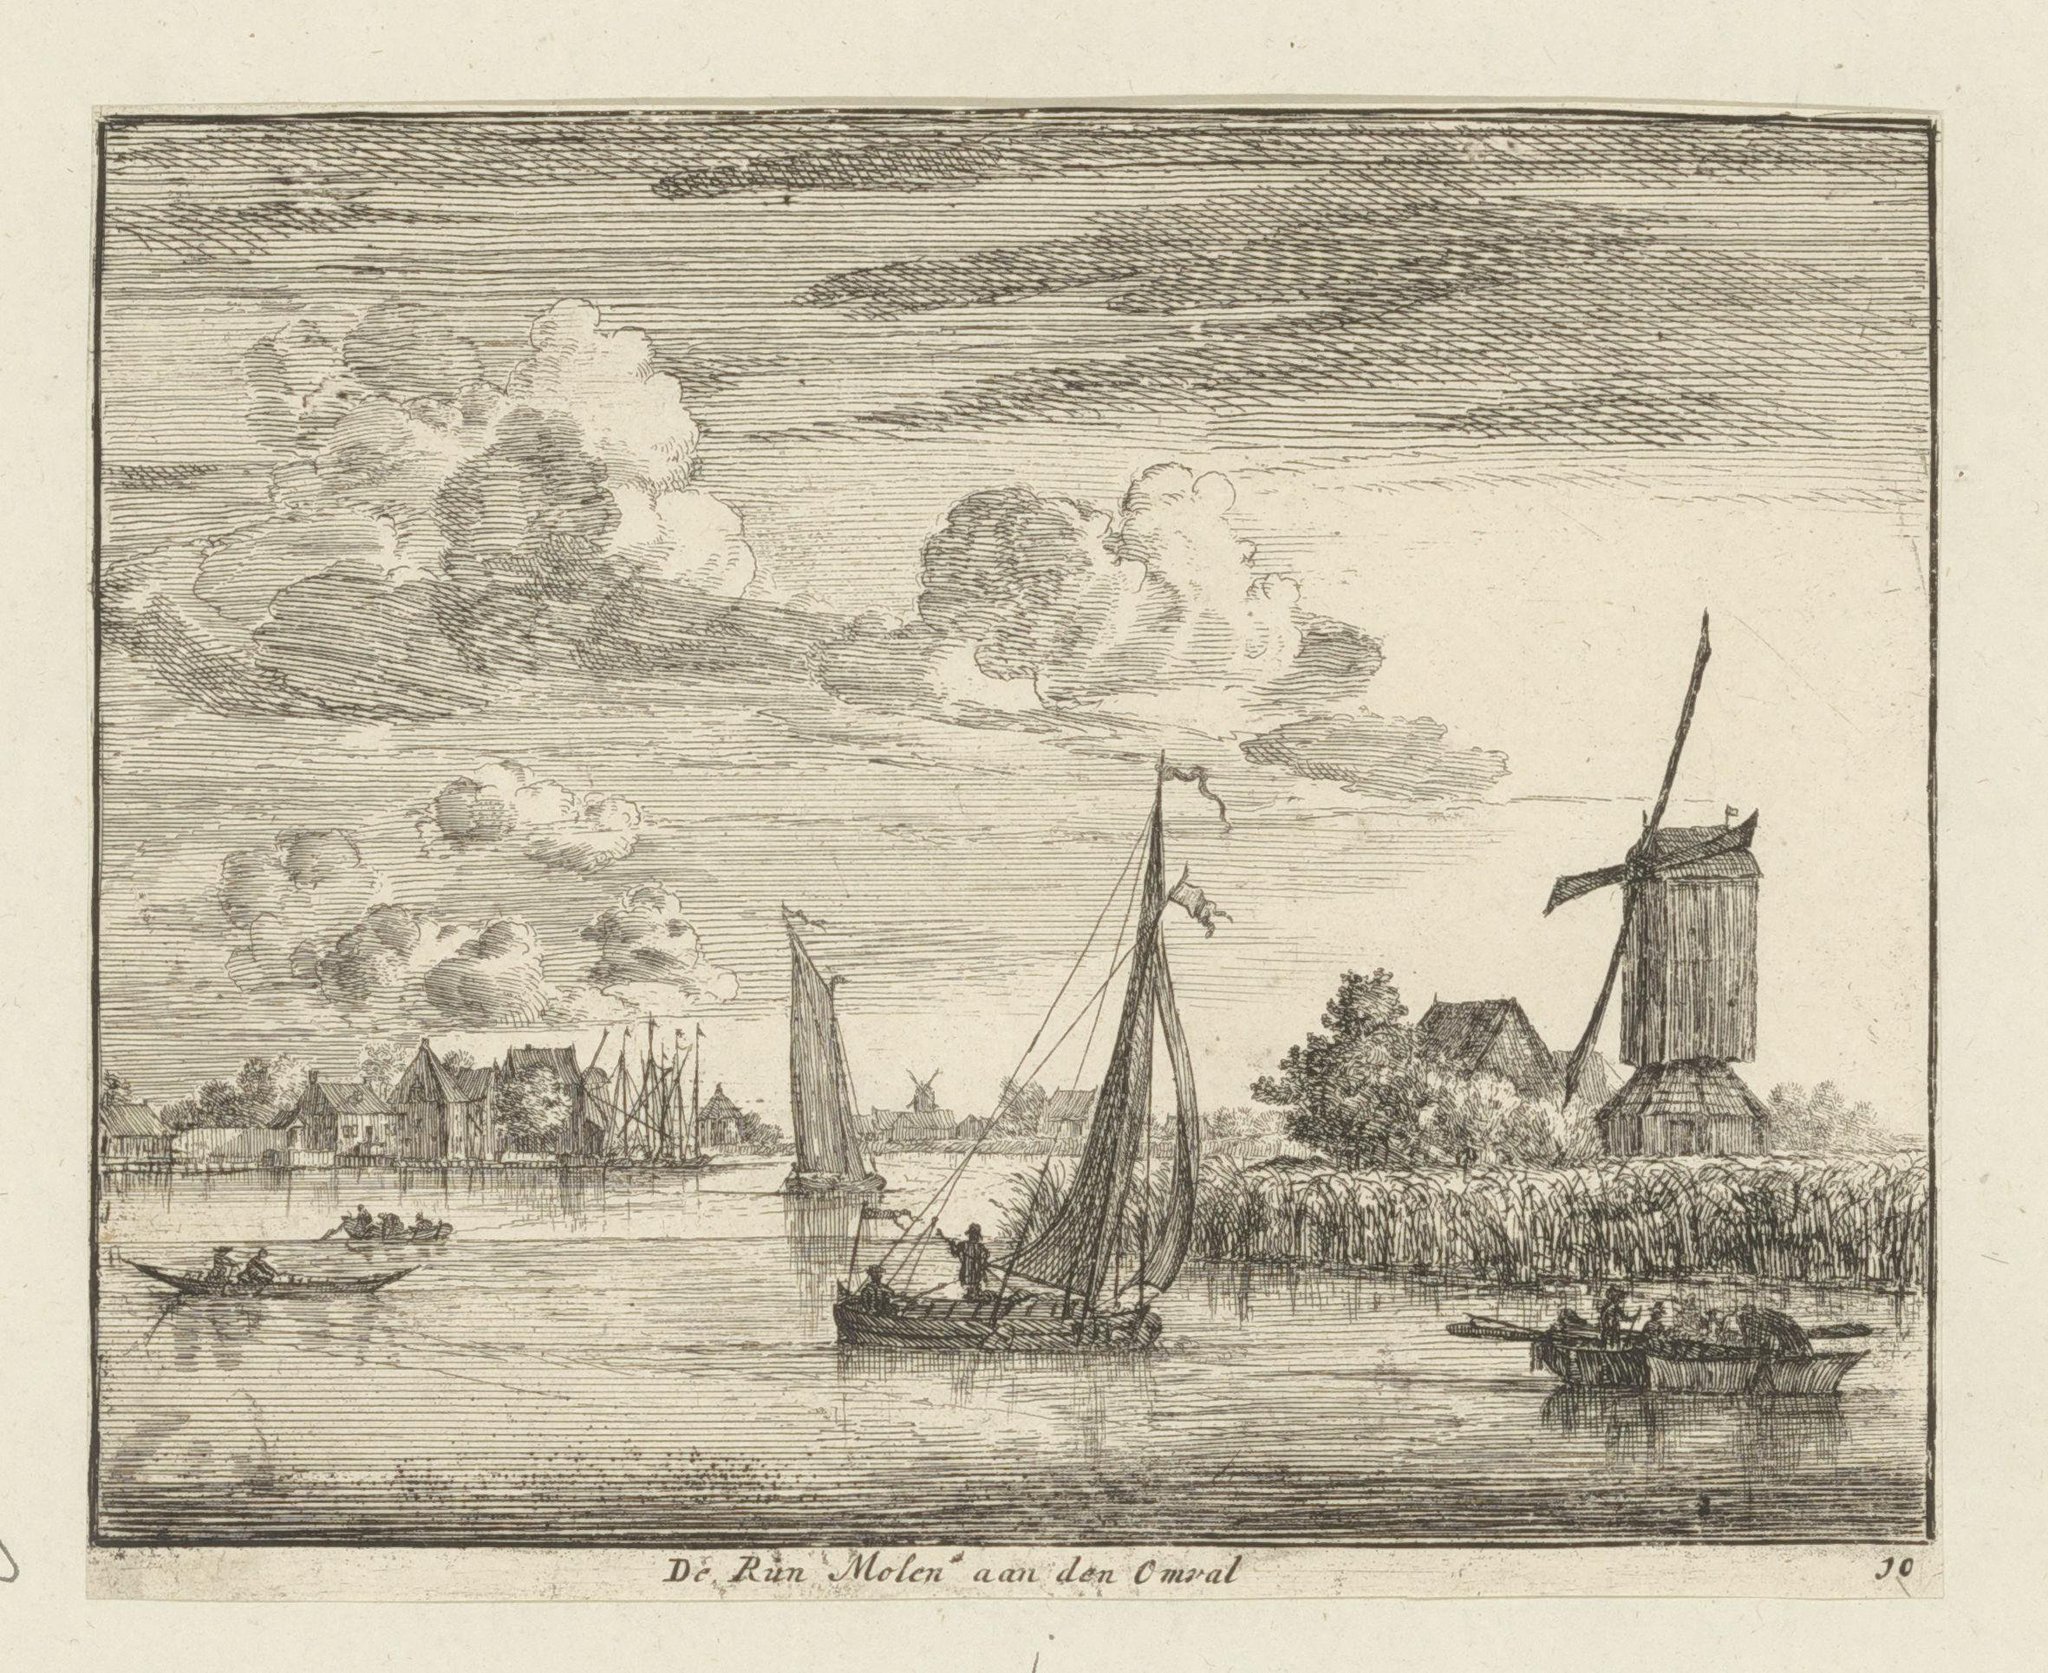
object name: print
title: Landschappen van de omgeving van Haarlem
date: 1688-1690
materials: paper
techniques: engraving, etching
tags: sailing-ship, sailing-boat, windmill, landscapes (+ landscape with figures, staffage), outskirts of village (+ city(-scape) with figures, staffage)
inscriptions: collector's mark: Lugt 1641, stamp, stamp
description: Gezicht op de schors- of runmolen aan de Omval. Op het water enkele roei- en zeilschepen. Rechtsonder genummerd: 10. Onderwerpsrubrieken binnen de Atlas Zeden en Gewoonten: Handel, nijverheid en verkeer, Buitenleven.